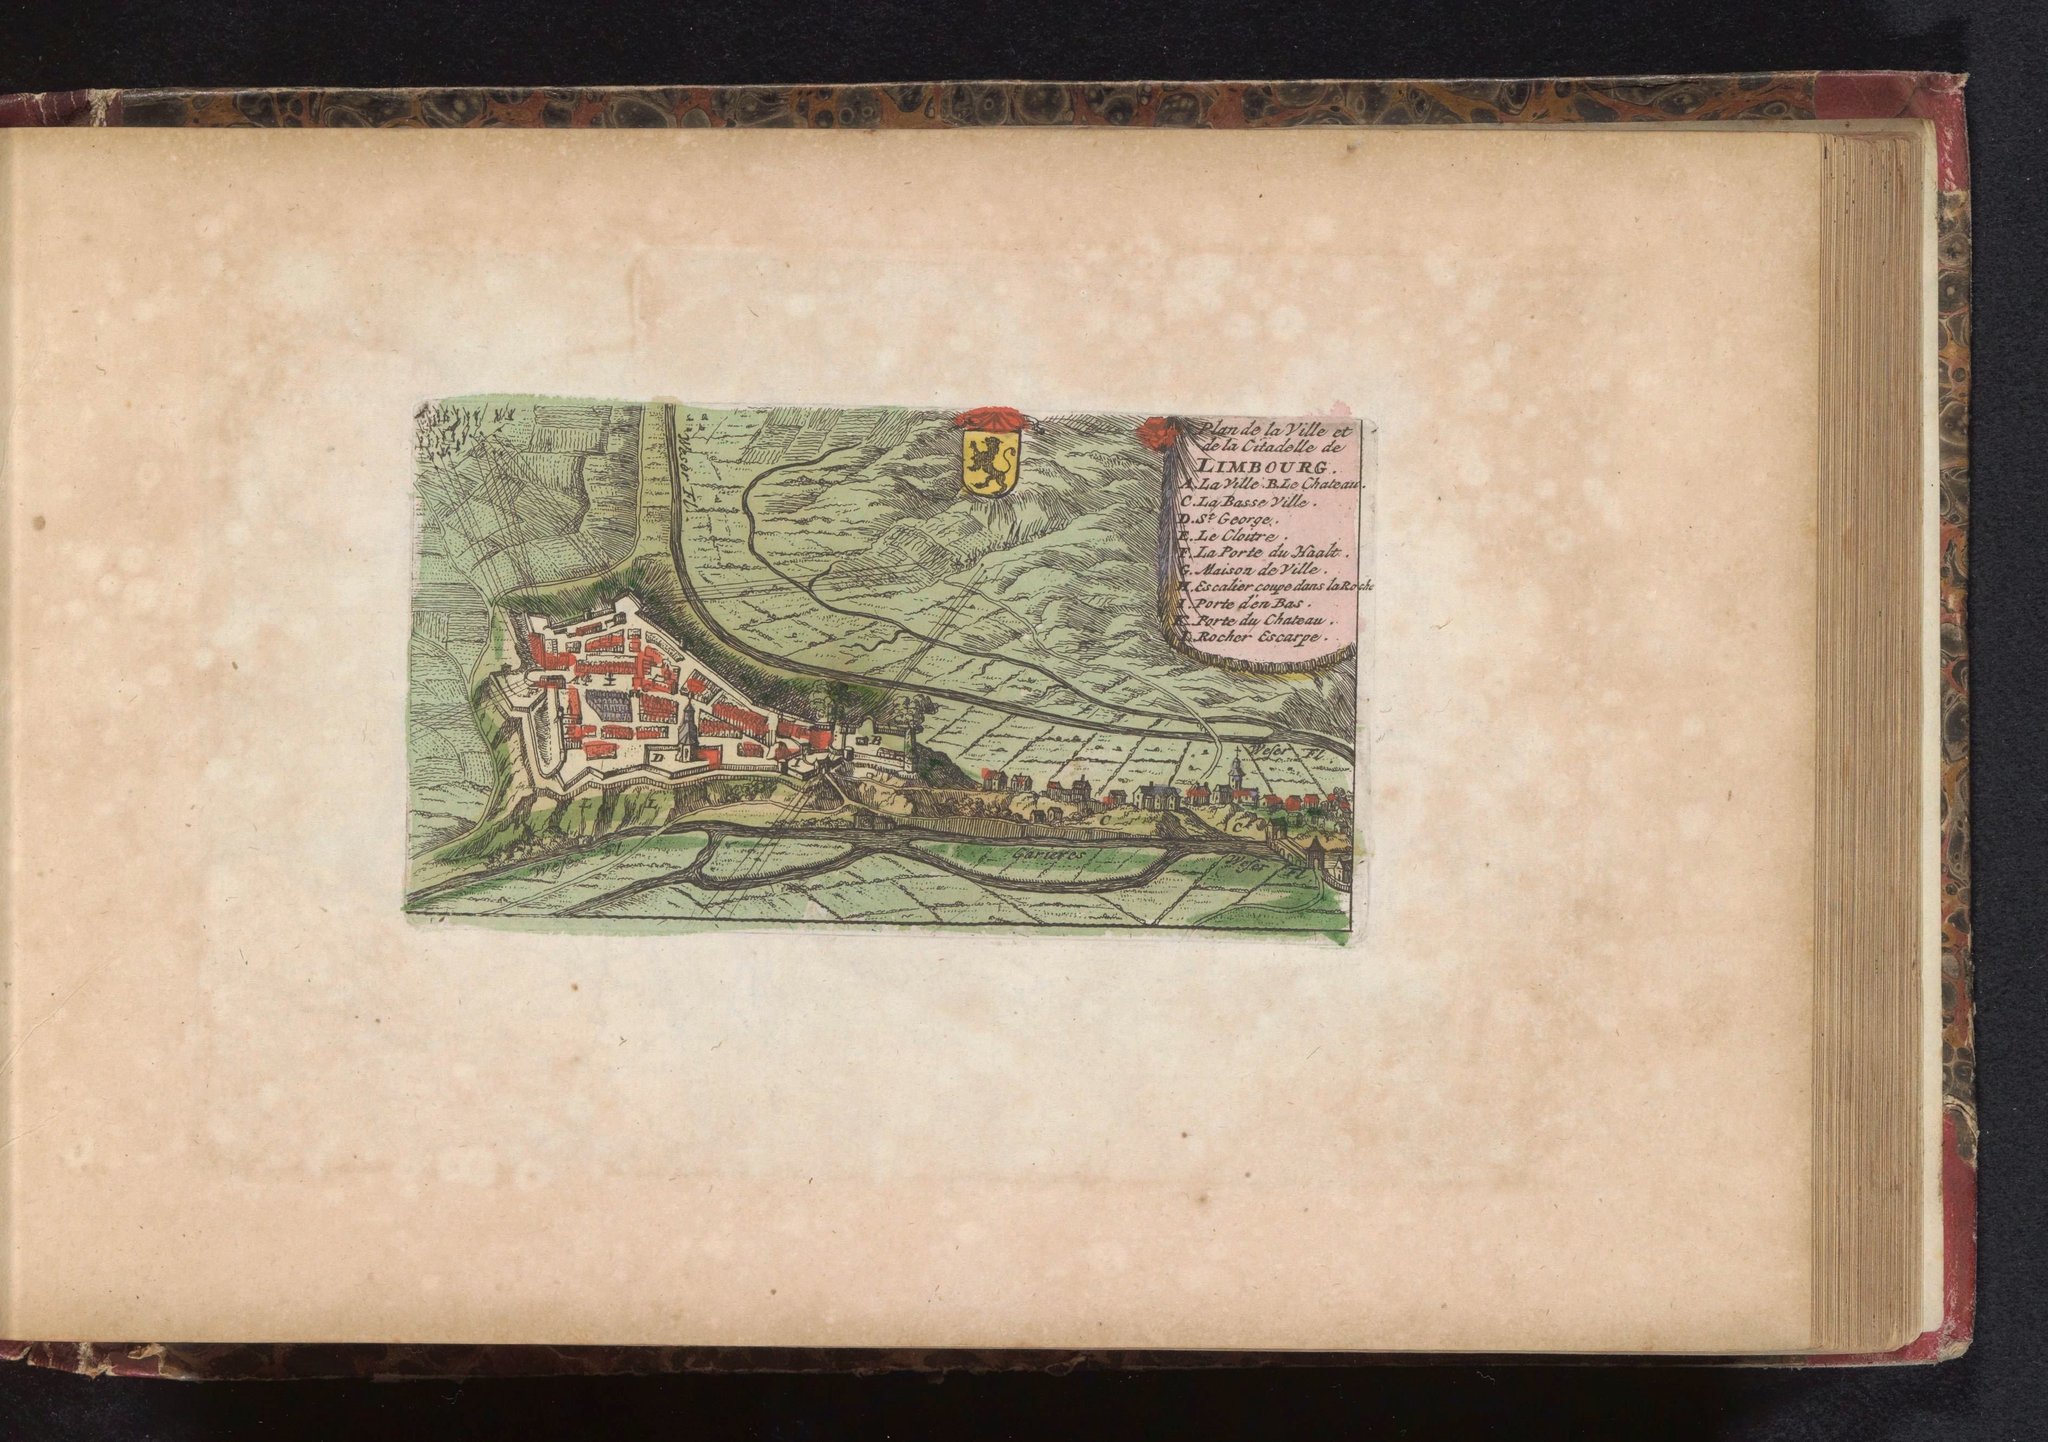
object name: map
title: Beschieting van Limbourg door de Geallieerden, 1703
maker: Anonymous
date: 1735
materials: paper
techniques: engraving, etching, hand coloring, lacquer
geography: northern netherlands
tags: siege, position war, maps of cities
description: Kaart in vogelvlucht met de beschieting van de stad Limbourg bij Luik door de Geallieerden, 27 september 1703. Onderdeel van een atlas met 223 kaarten van landen en steden en oorlogstaferelen in Europa in de periode ca. 1690-1735.